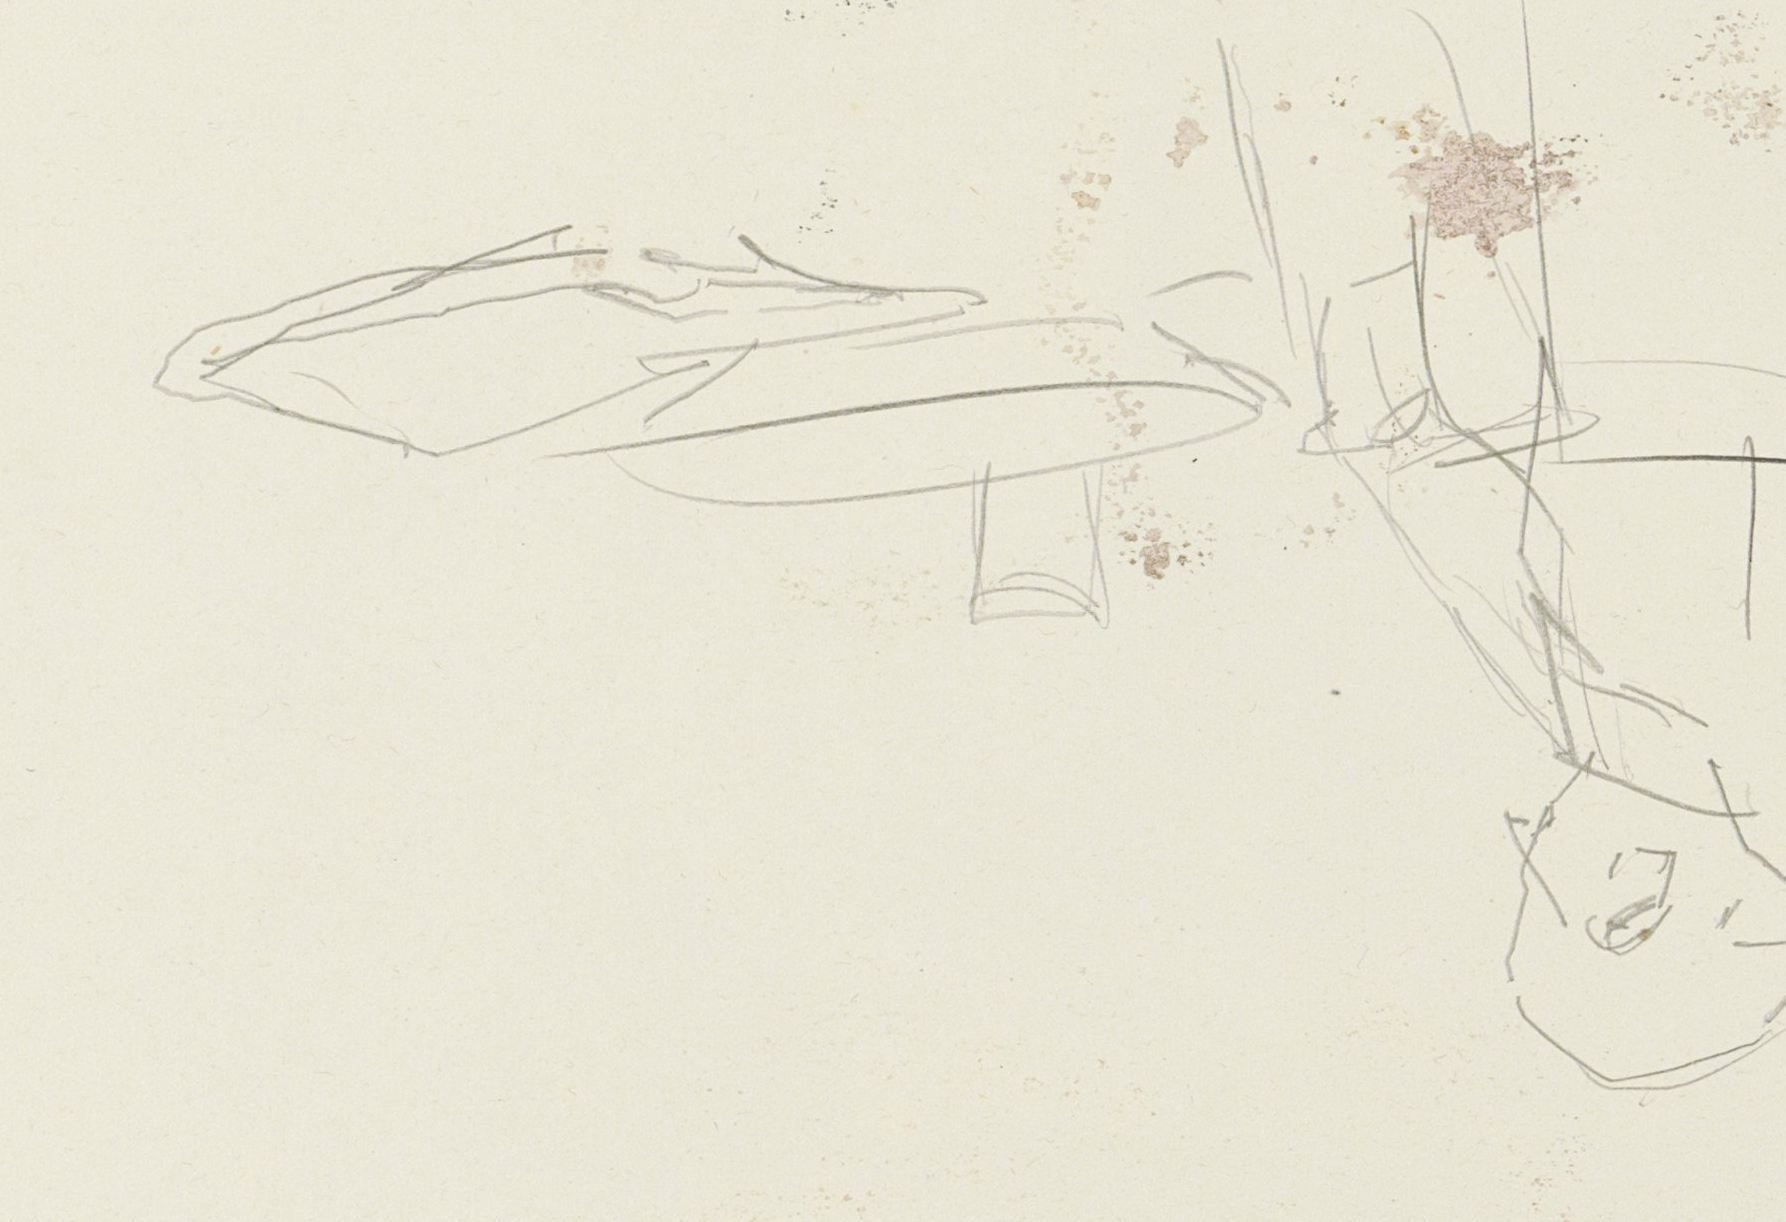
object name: sketchbook leaf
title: Man aan een tafel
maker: isaac israels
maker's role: draughtsman, painter, print maker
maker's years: 1865-1934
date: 1875-1934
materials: paper, pencil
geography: the hague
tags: adult man (+ sitting), table, chair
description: Blad 4 verso uit schetsboek XXVIII met 17 bladen.